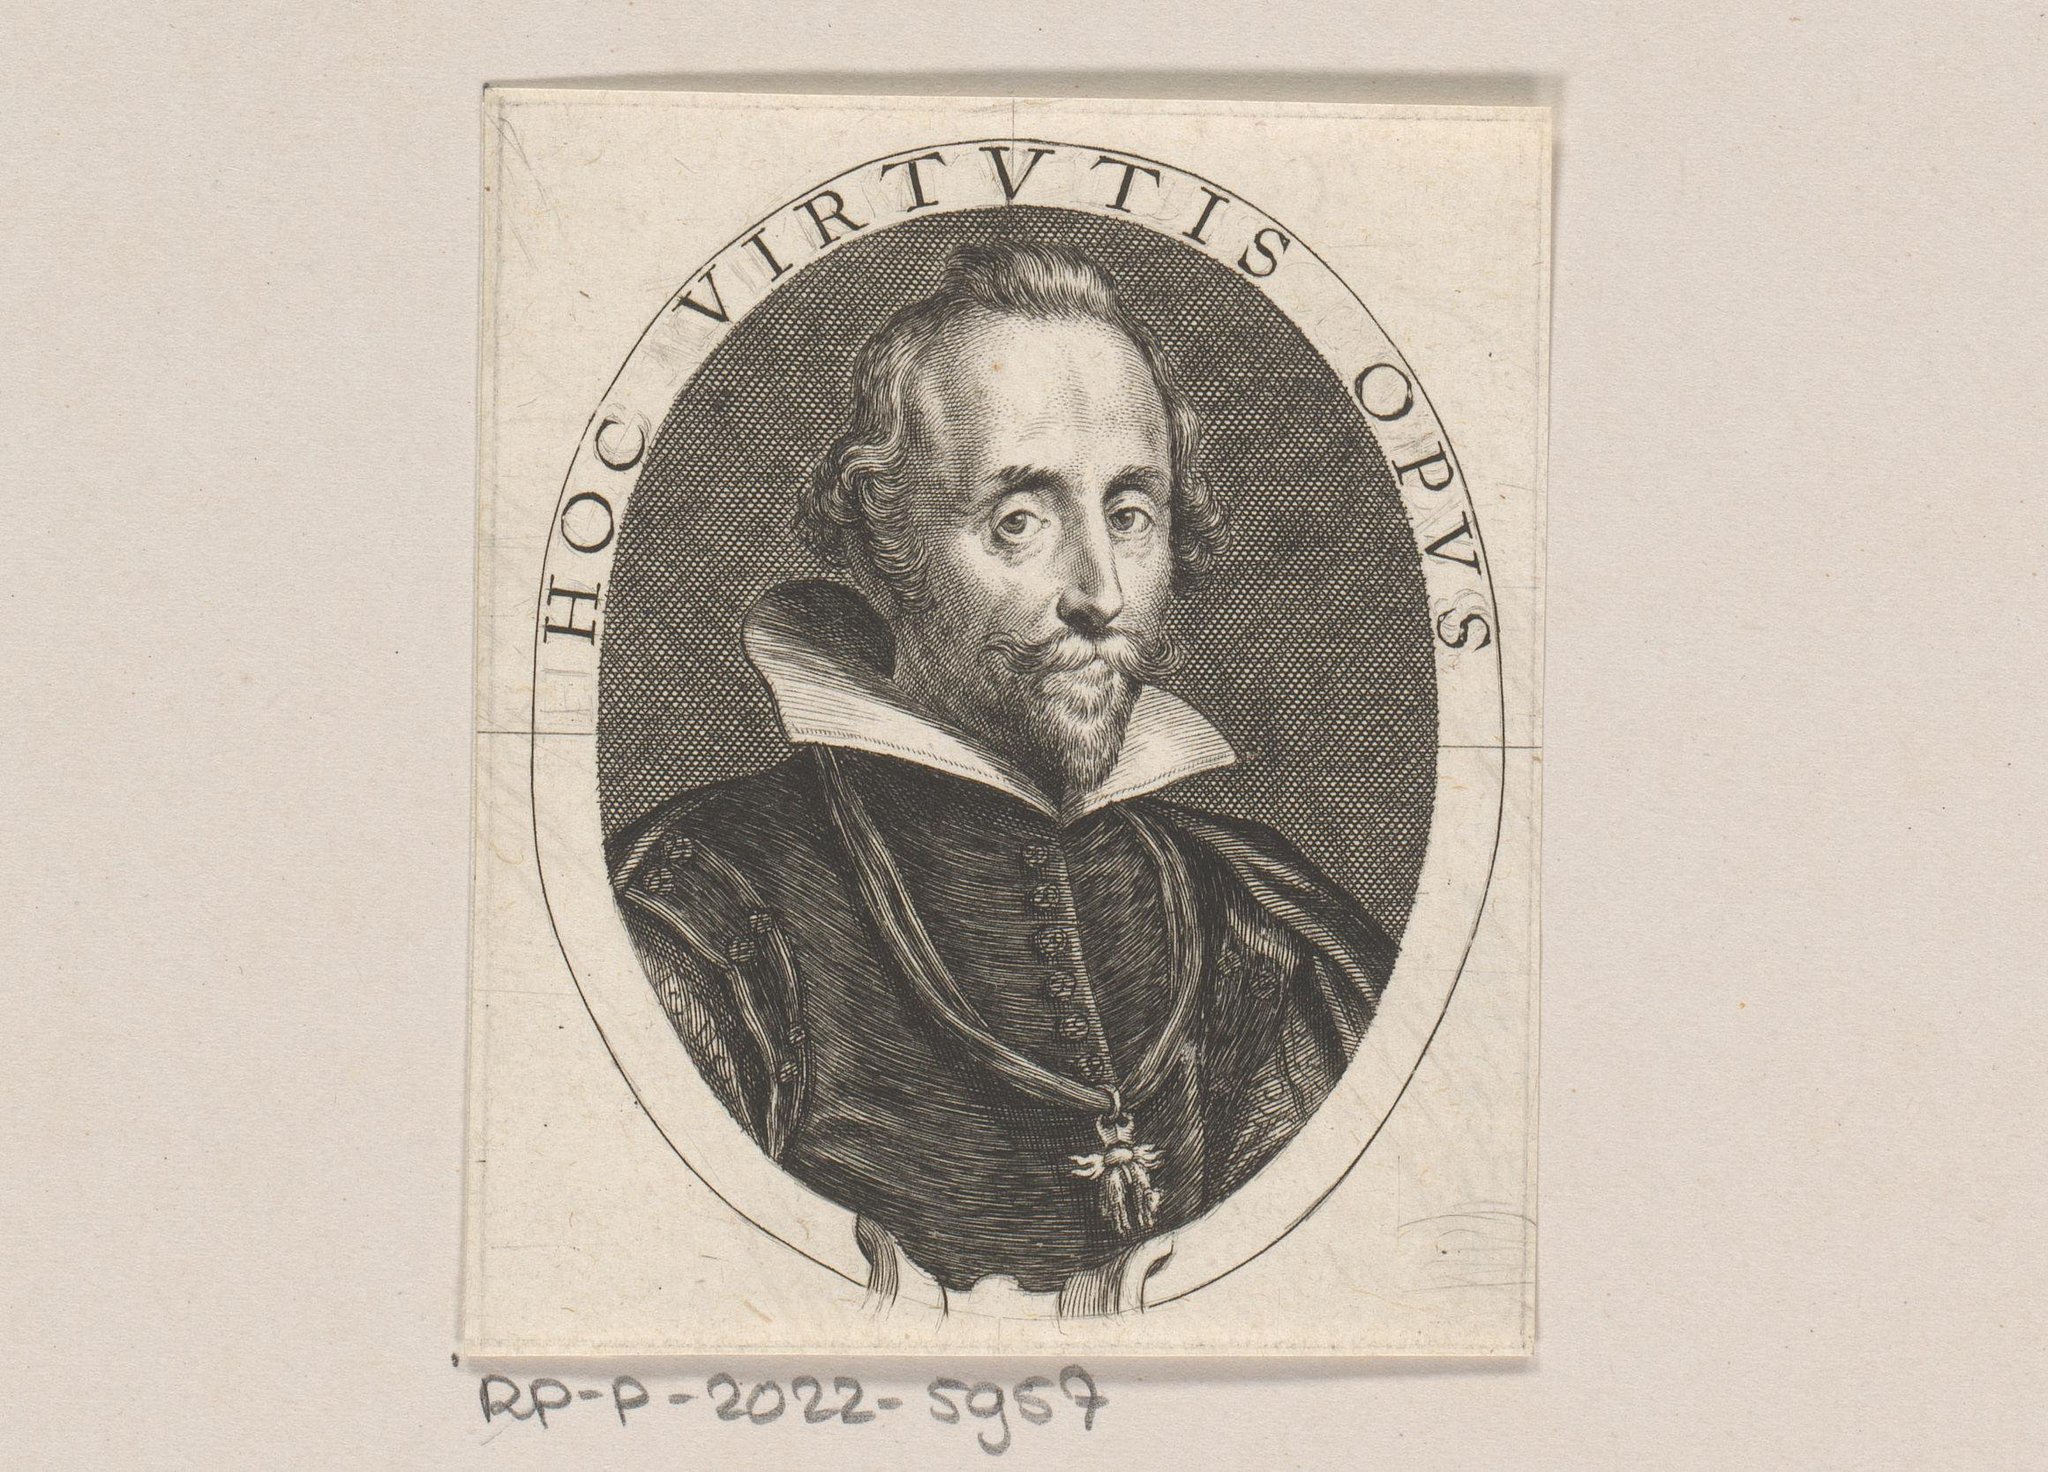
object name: print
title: Portret van Wolfgang Willem van de Palts-Neuburg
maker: Anonymous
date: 1630-1699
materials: paper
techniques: engraving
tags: wolfgang willem van de palts-neuburg, historical persons, knighthood order of the golden fleece, ruler, sovereign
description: Met tekst in het Latijn rondom het portret.